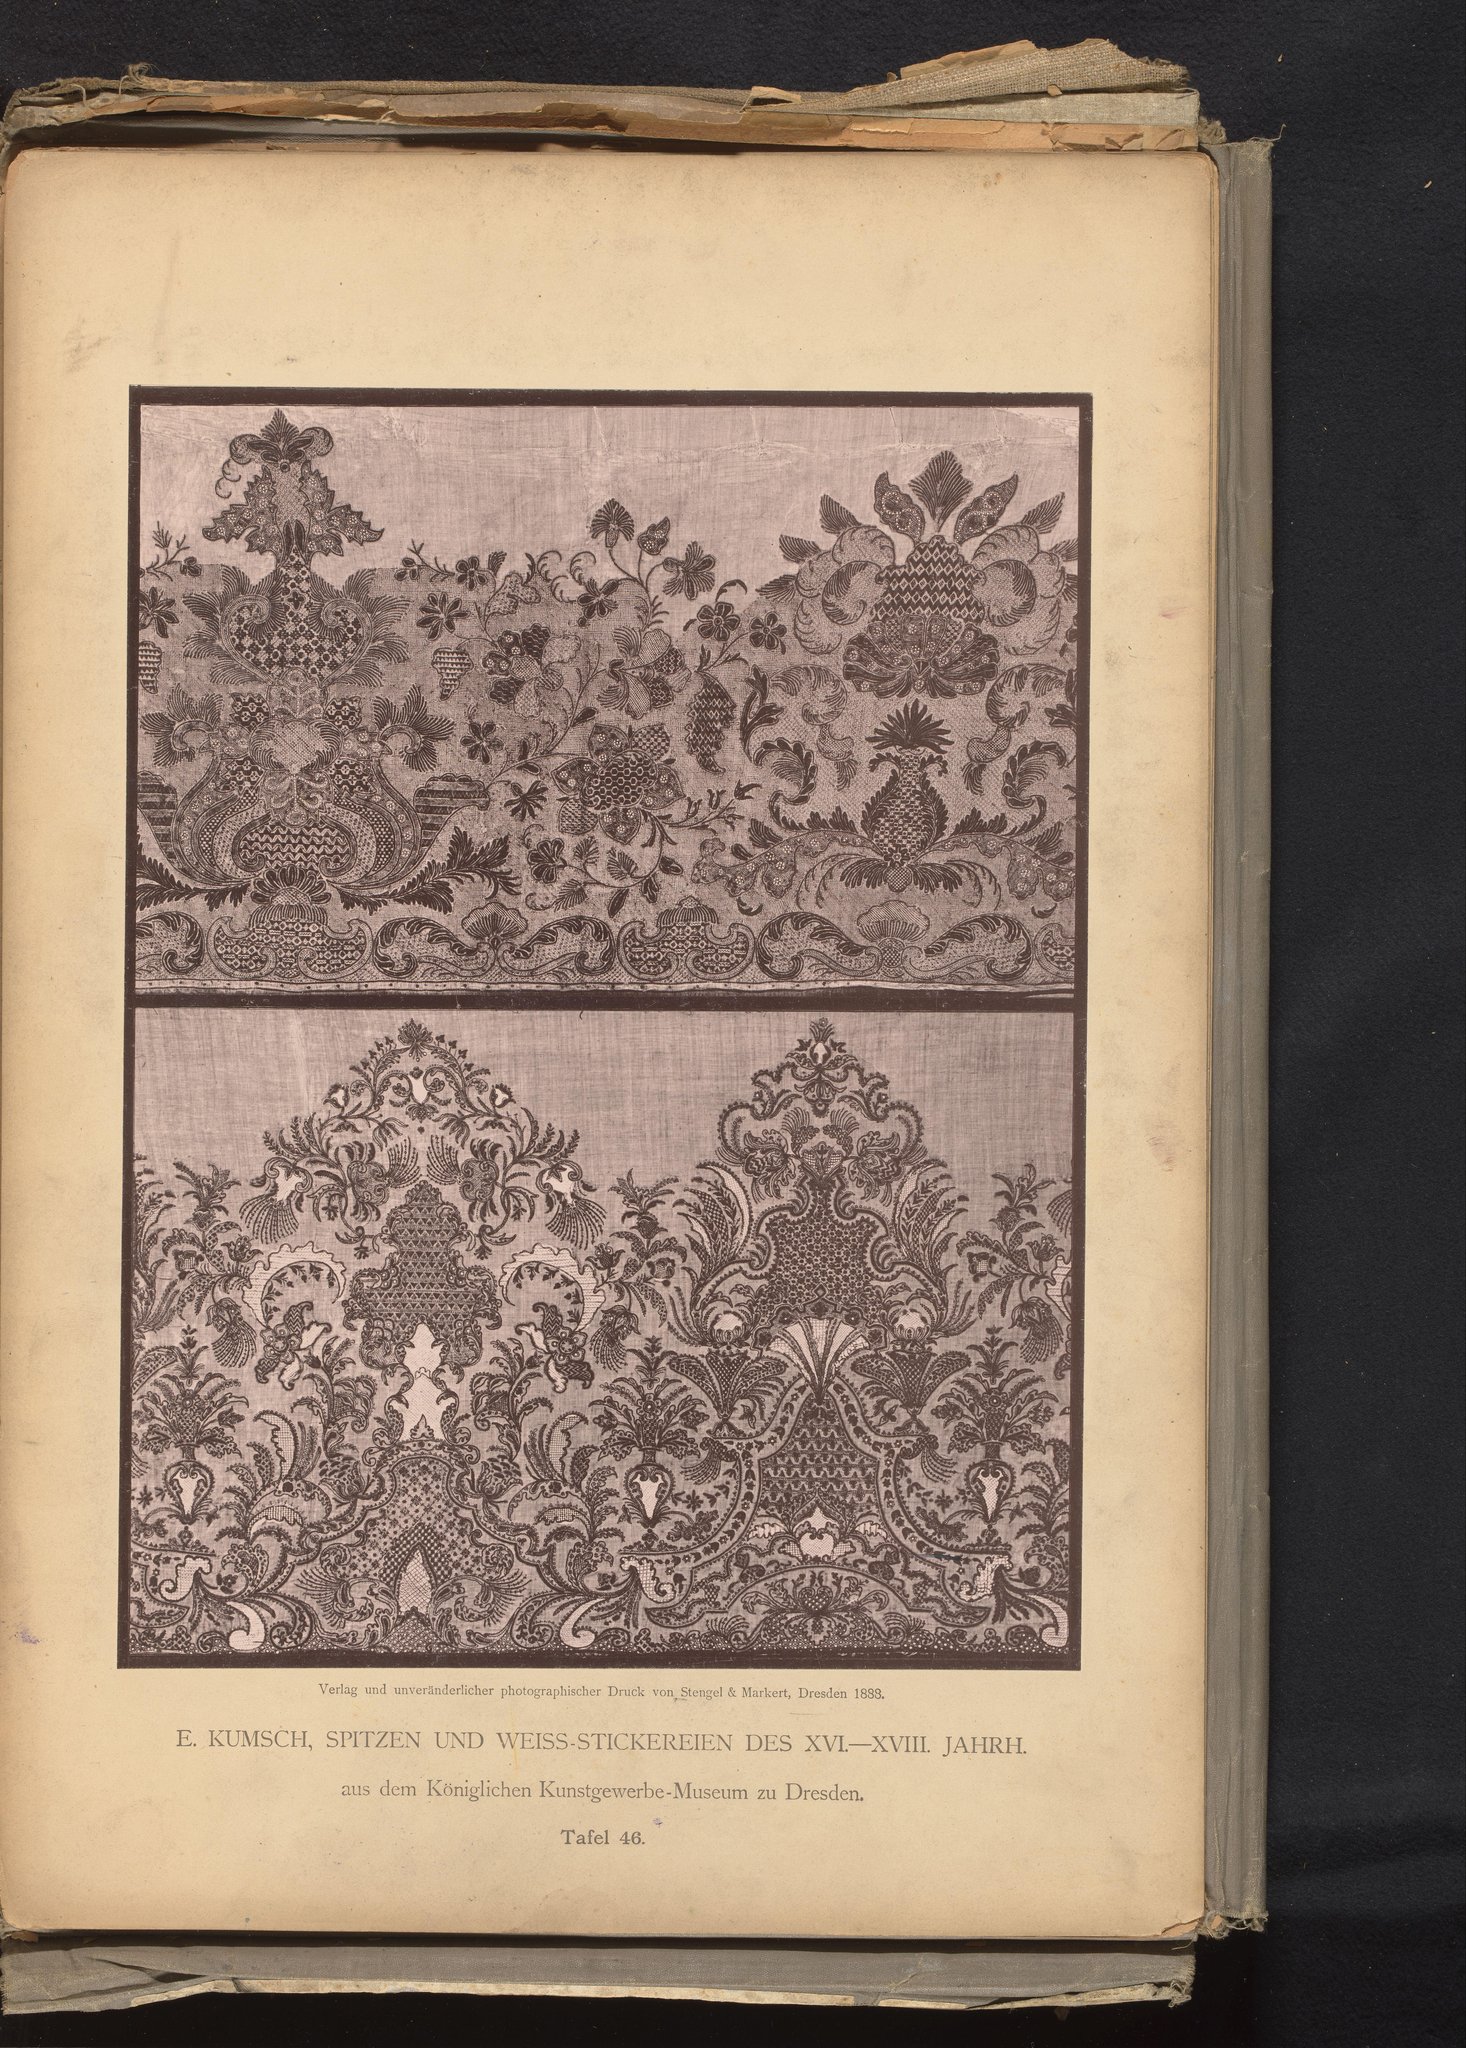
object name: photomechanical print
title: Twee stukken 18de-eeuws Duits borduurwerk uit de collectie van het Kunstgewerbemuseum in Dresden, Duitsland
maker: Anonymous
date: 1888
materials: paper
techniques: photograph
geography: dresden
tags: embroidery (ornamentation)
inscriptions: number: ‘Tafel 46.’, inscription: ‘E. KUMSCH, SPITZEN UND WEISS-STICKEREIEN DES XVI.-XVIII. JAHRH./ aus dem Königlichen Kunstgewerbe-Museum zu Dresden’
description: Deze prent maakt deel uit van een omslag met 49 prenten en een lijst van afbeeldingen.